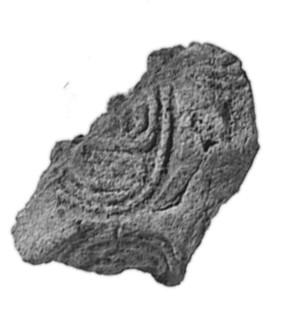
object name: sealing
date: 2030-1640 BCE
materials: clay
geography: egypt